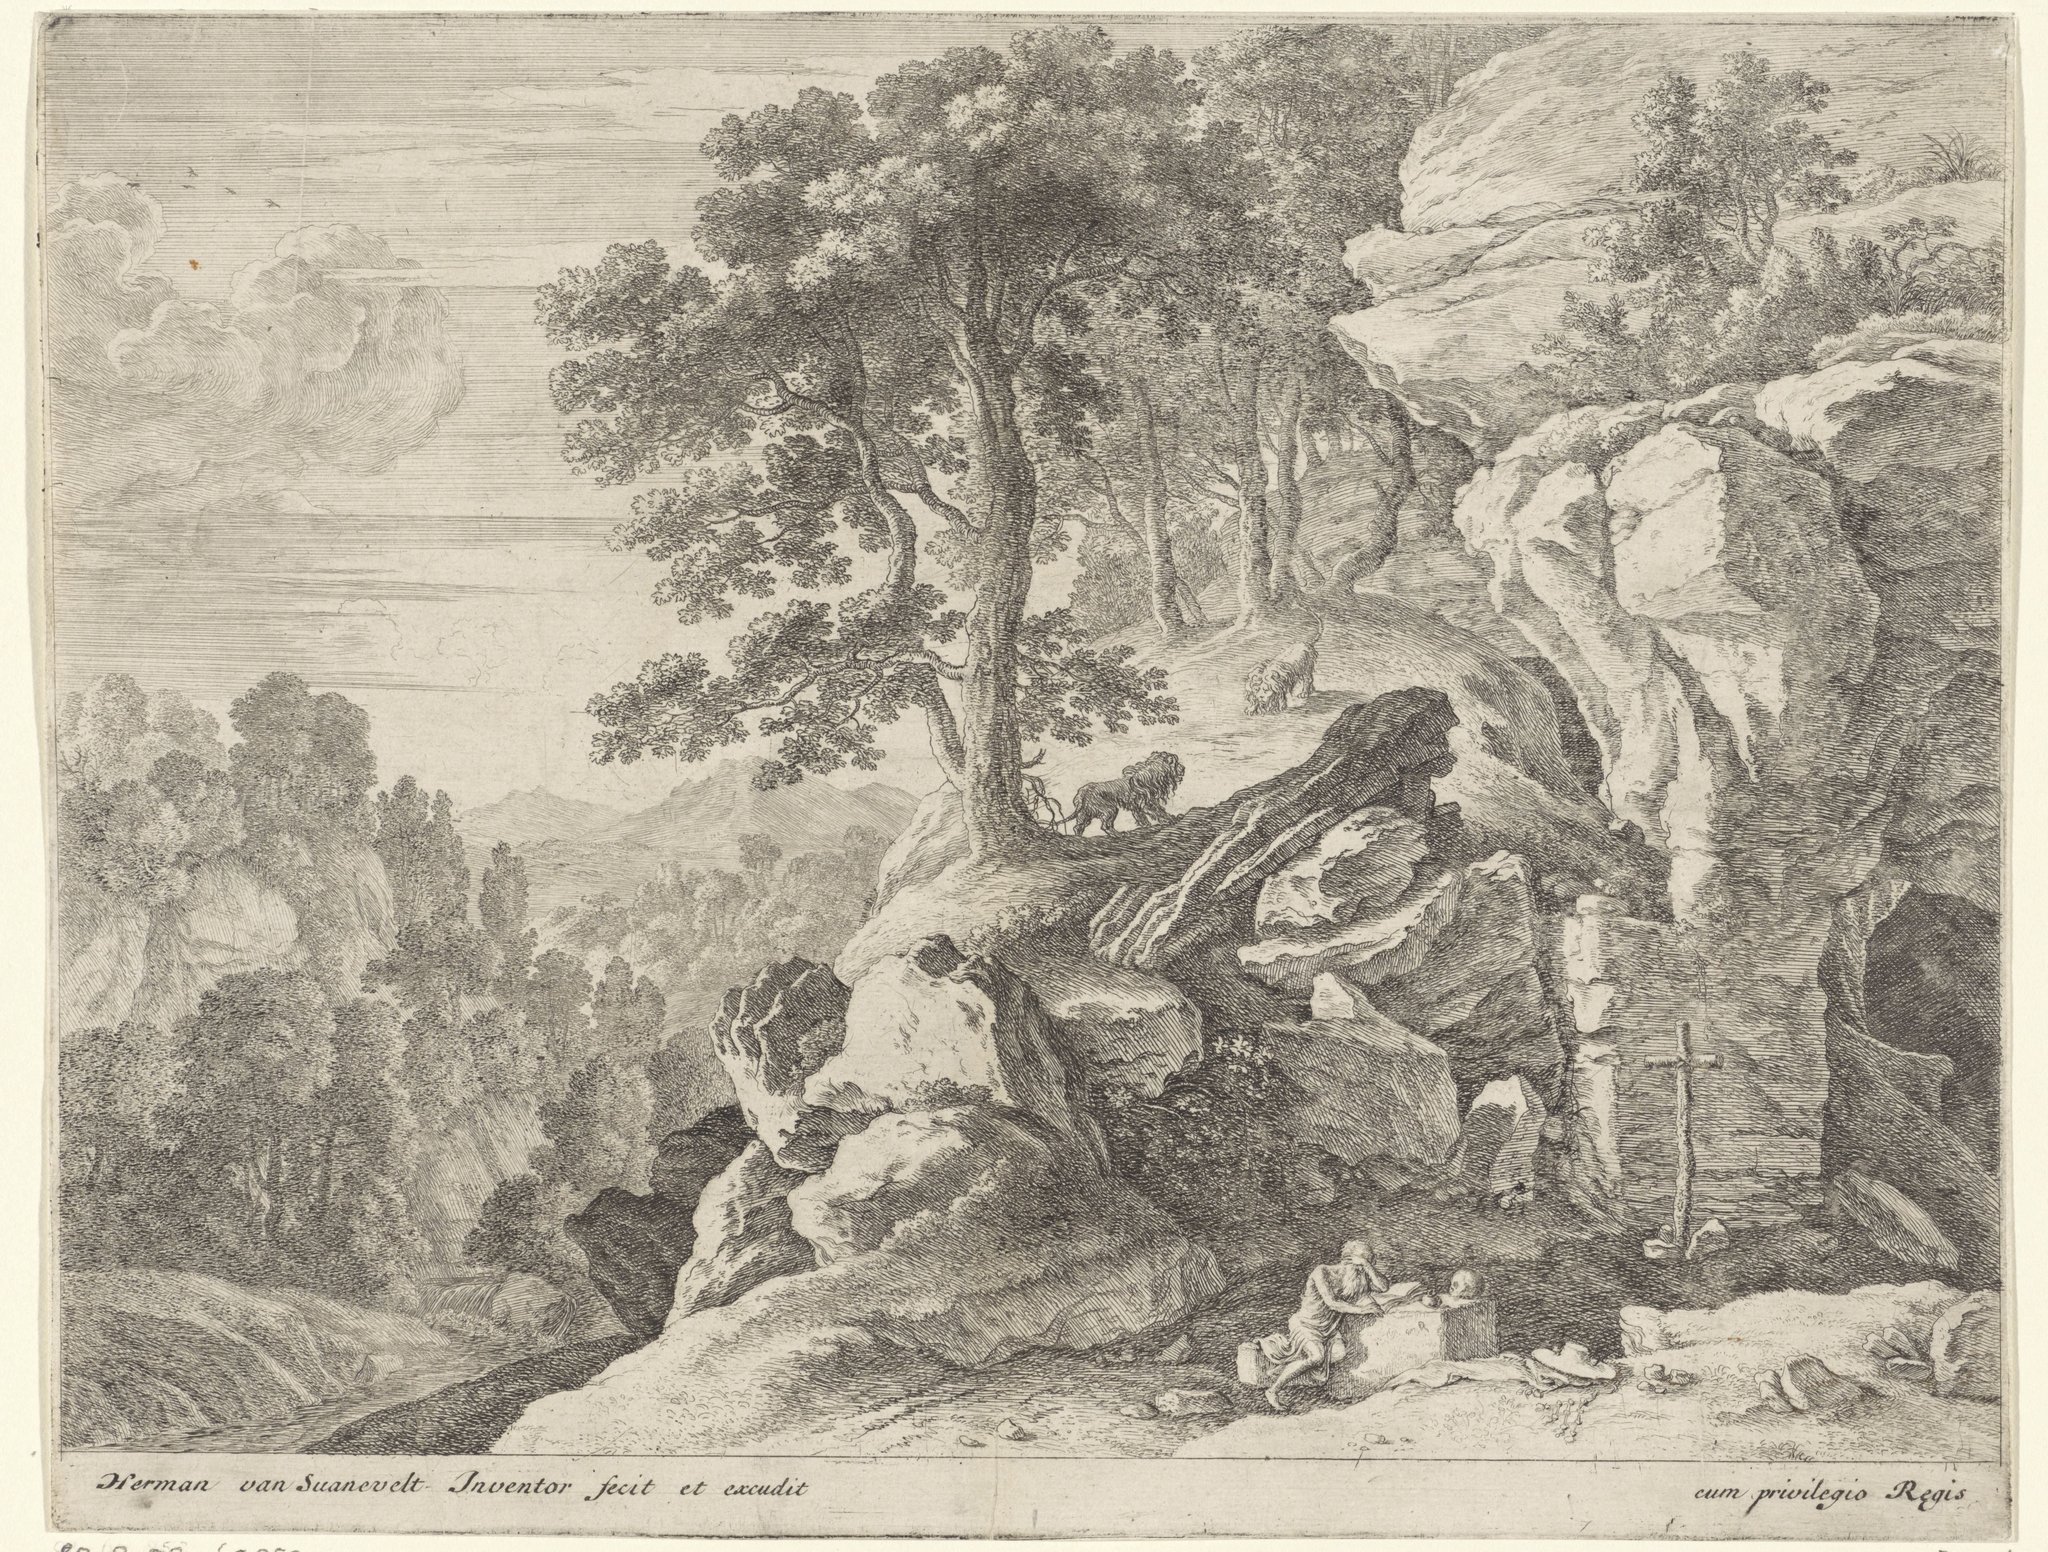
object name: print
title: Landschappen met boetvaardige heiligen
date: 1650-1655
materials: paper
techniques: etching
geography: paris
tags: st. jerome as penitent in the desert, half naked, kneeling before a crucifix and holding a stone in his hand to beat his breast; a skull (and other 'vanitas' symbols), sometimes a scorpion and a snake beside him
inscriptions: collector's mark: Lugt 240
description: In een rotsachtig landschap met boompartijen zit de heilige Hieronymus rechts op de voorgrond gebogen over een boek. In zijn rechterhand houdt hij schrijfgerei. Voor hem ligt een doodskop en inktpot op een stuk steen. Op de rots voor hem ligt een mantel en een kardinaalshoed. Rechts staat een kruis en op de achtergrond staan twee leeuwen tegenover elkaar.